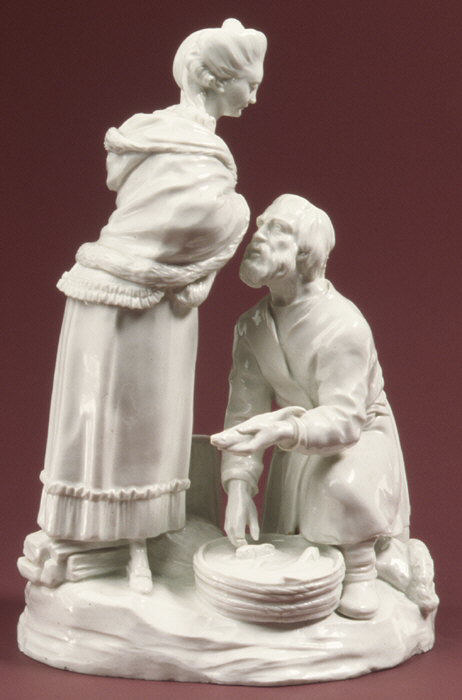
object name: group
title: Fisherman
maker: imperial porcelain manufactory, st. petersburg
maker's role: manufactory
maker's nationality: russian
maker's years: 1744-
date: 1780-1800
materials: hard paste porcelain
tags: men,women